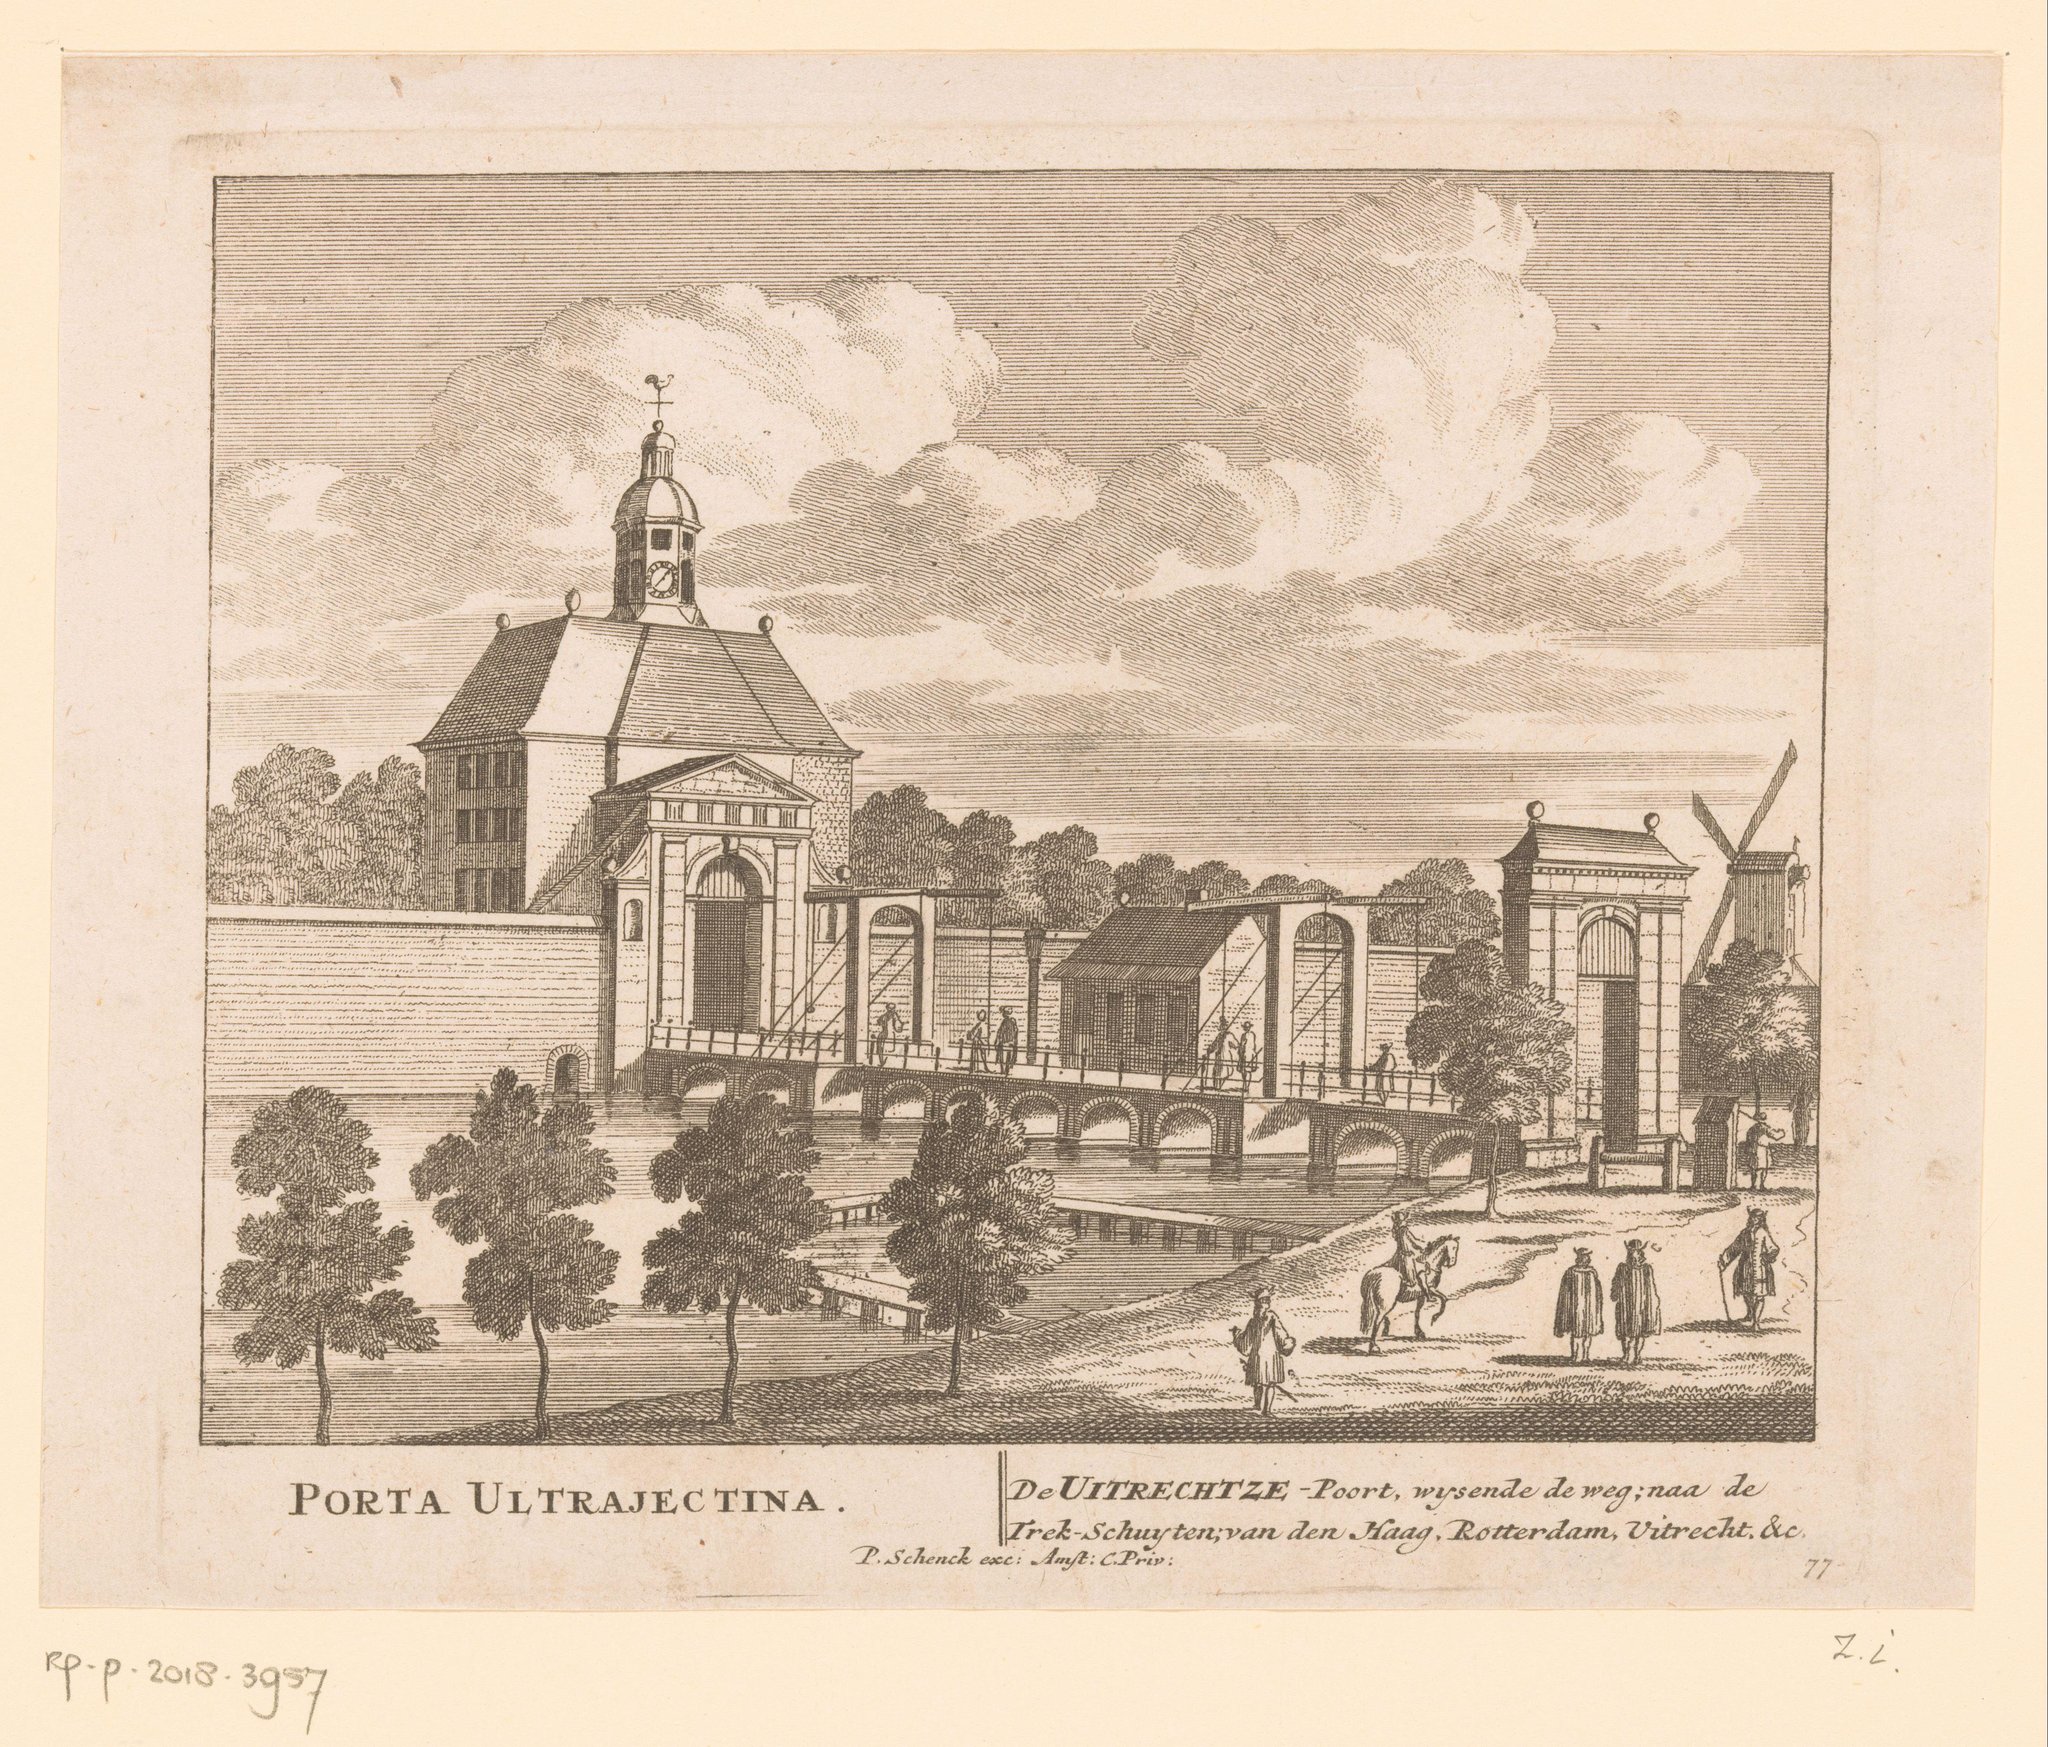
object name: print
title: Porta Ultrajectina / De Uitrechtze-poort, wysende de weg; naa de trek-schuyten; van Den Haag, Rotterdam, Uitrecht, &c.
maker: Anonymous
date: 1710-1711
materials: paper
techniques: engraving, etching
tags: bridge in city across river, canal, etc., city-gate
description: Prent uit: 100 Afbeeldinge der voornaamste gebouwen van Amsterdam. Amsterdam, Pieter Schenk (I), s.a. [1710-1711]. Of: 100 Afbeeldinge der voornaamste gebouwen van Amsterdam. Amsterdam, Barent Greve, [1757-1766], prent nummer 77. In de tweede uitgave, uitgegeven door Barent Greve, is alleen de titelprent aangepast. De overige prenten zijn onveranderd gebleven.